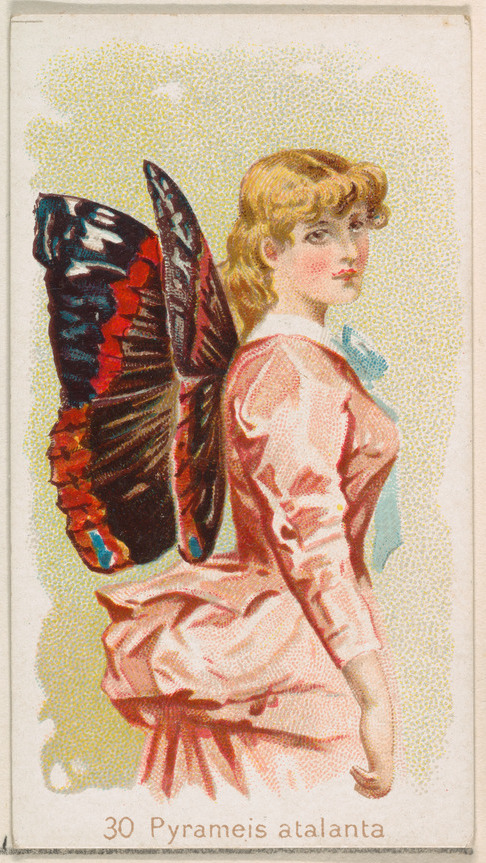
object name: print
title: Card 30, Pyrameis Atalanta, from the Butterflies series (N183) issued by Wm. S. Kimball & Co.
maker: william s. kimball & company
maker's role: publisher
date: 1888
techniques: color lithograph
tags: women,butterflies